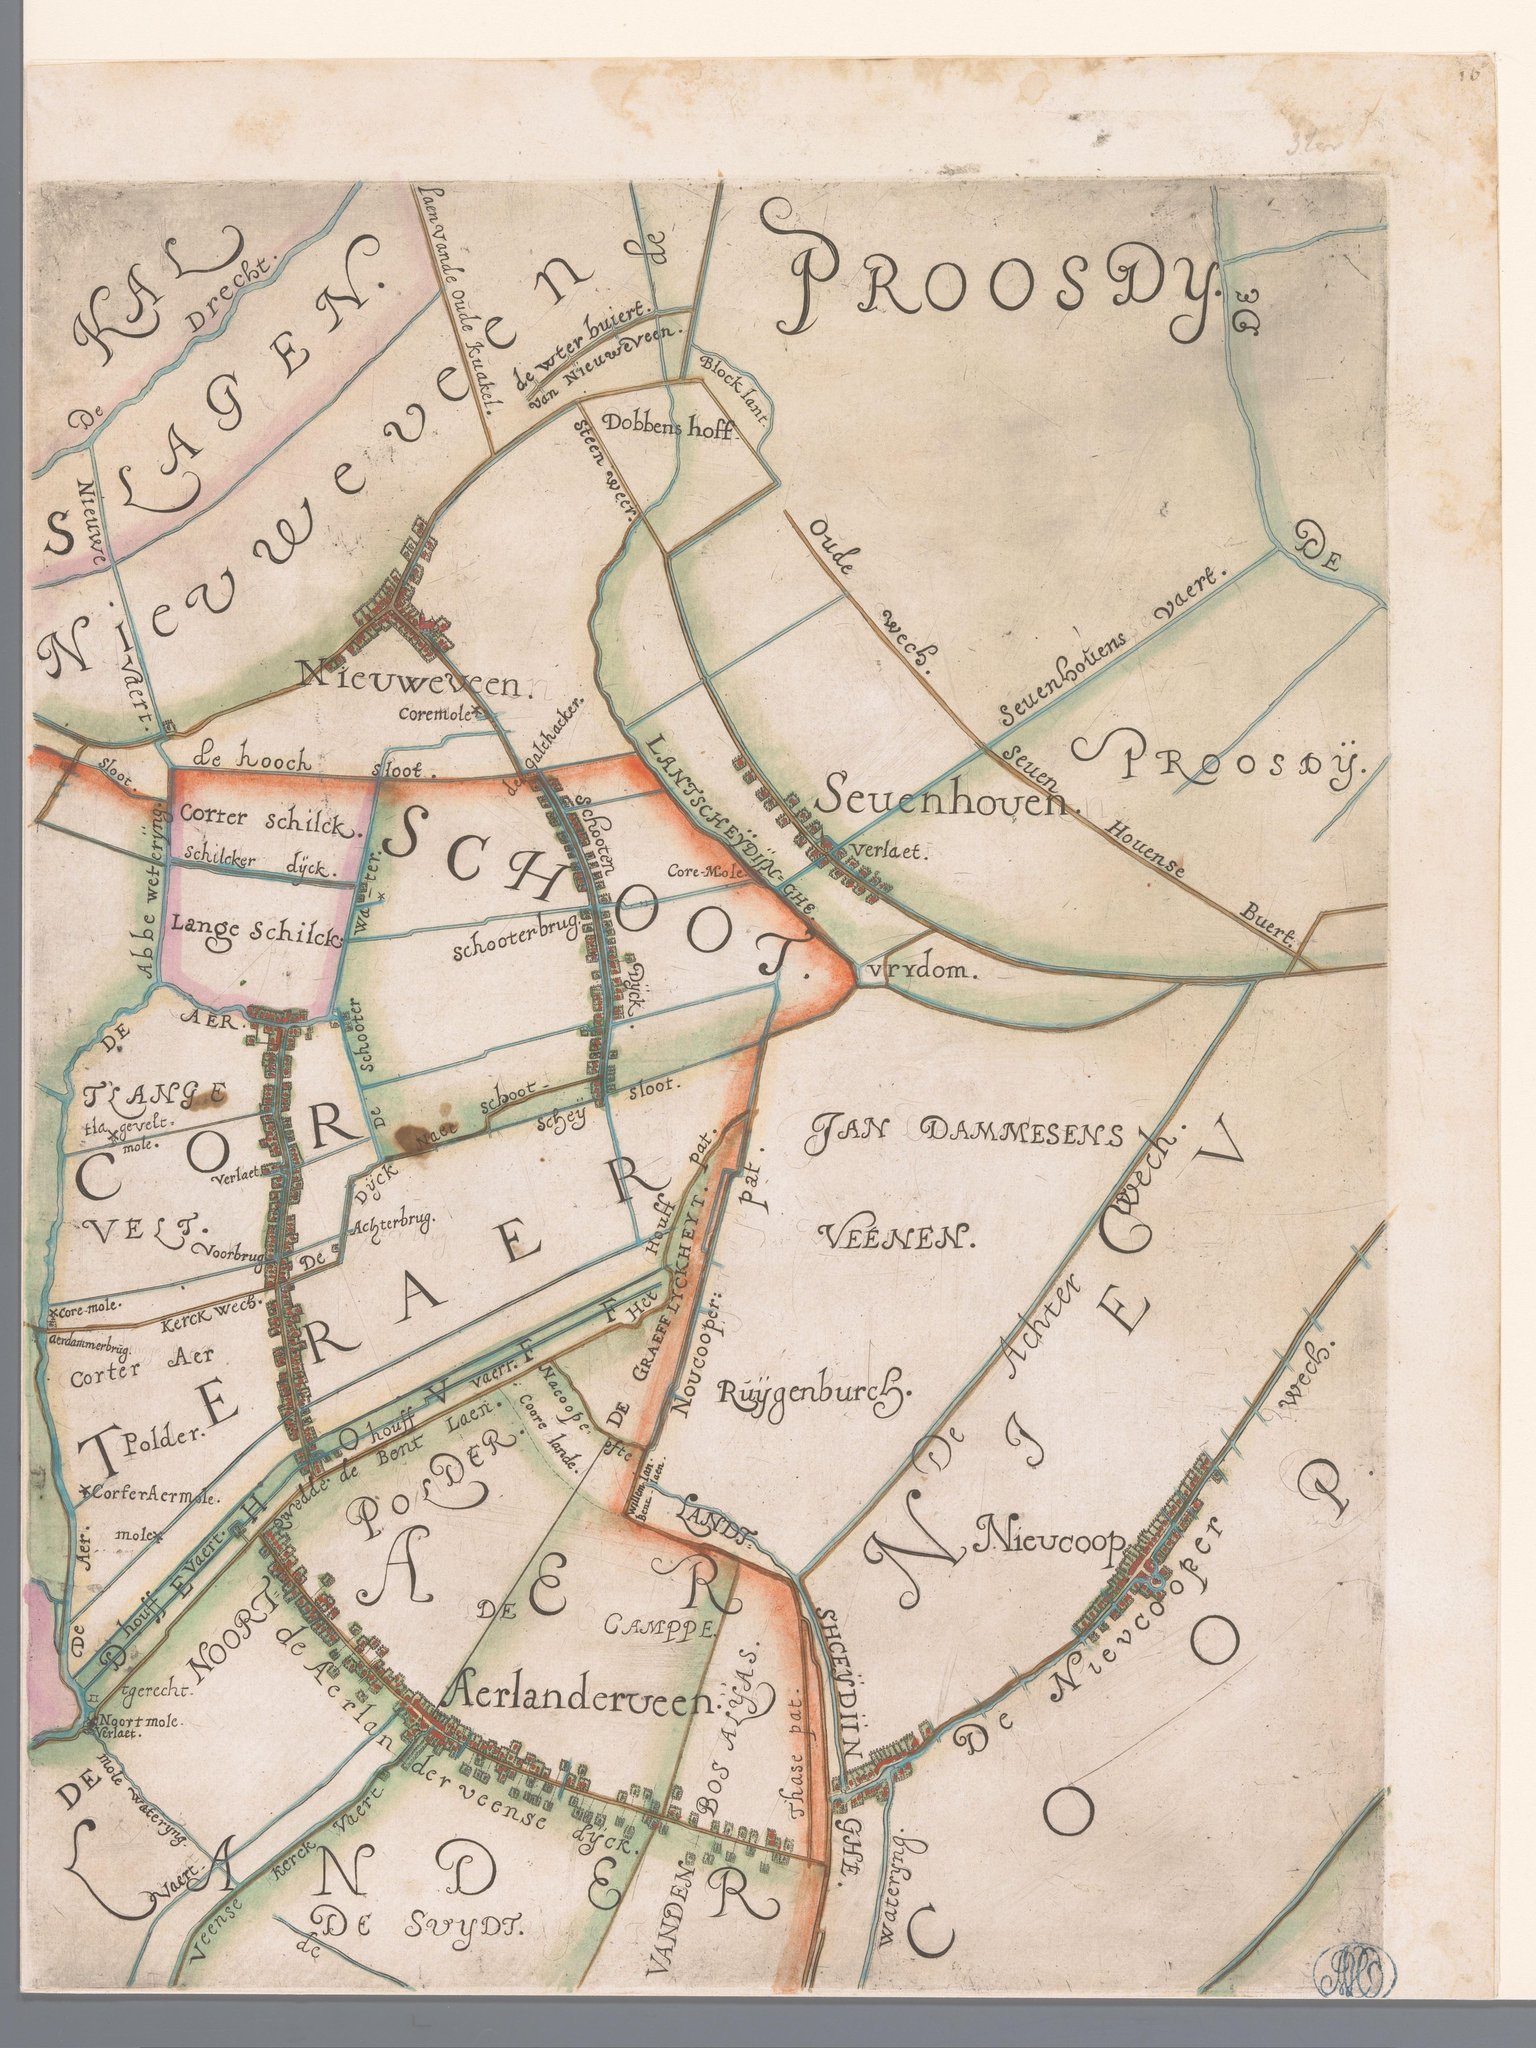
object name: print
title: Deel van een kaart van het Hoogheemraadschap van Rijnland, met Nieuwveen en Nieuwkoop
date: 1615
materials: paper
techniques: engraving, etching, hand coloring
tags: maps of separate countries or regions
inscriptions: collector's mark: Lugt 195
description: Deel van een kaart van Rijnland, bestaande uit 27 delen.